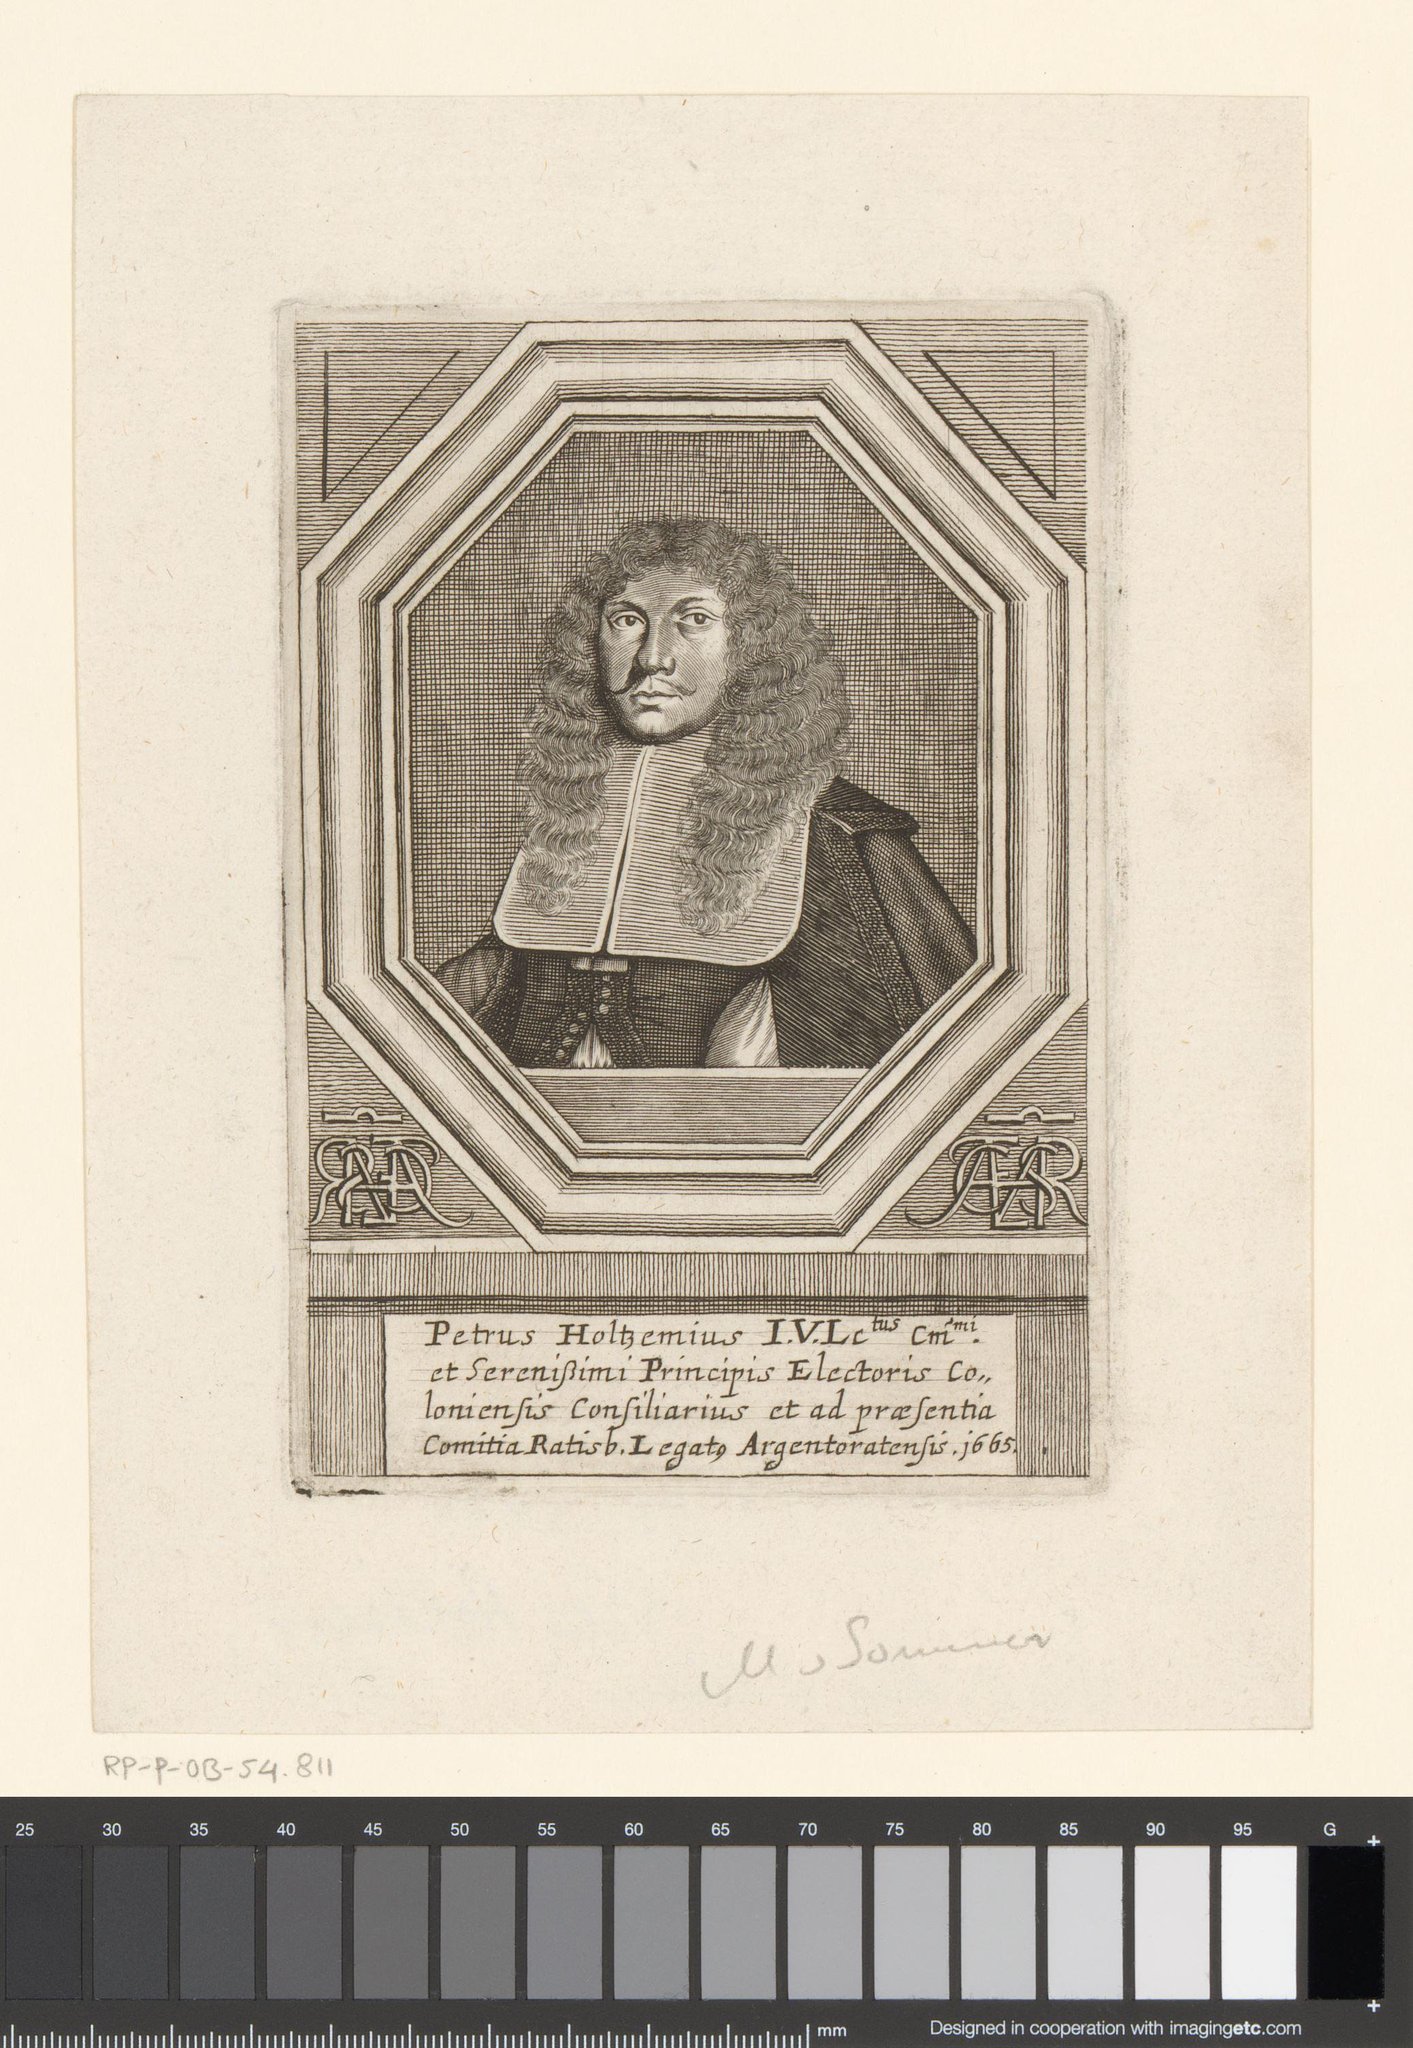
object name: print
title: Portret van Petrus Holtzemius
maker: matthias van sommer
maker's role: draughtsman, print maker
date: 1665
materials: paper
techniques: engraving, etching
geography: germany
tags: historical persons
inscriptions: collector's mark: Lugt 2228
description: Volgens Hollstein werd de prent gebruikt voor de publicatie: Sommer, Matthias van. Hasce Omnium Electorum. Regensburg: s.n., 1667. Alhoewel op de titelpagina van de publicatie het jaar 1667 wordt vermeld, zijn meerdere prenten later gedateerd. Waarschijnlijk werd de publicatie pas in 1671 daadwerkelijk uitgegeven.